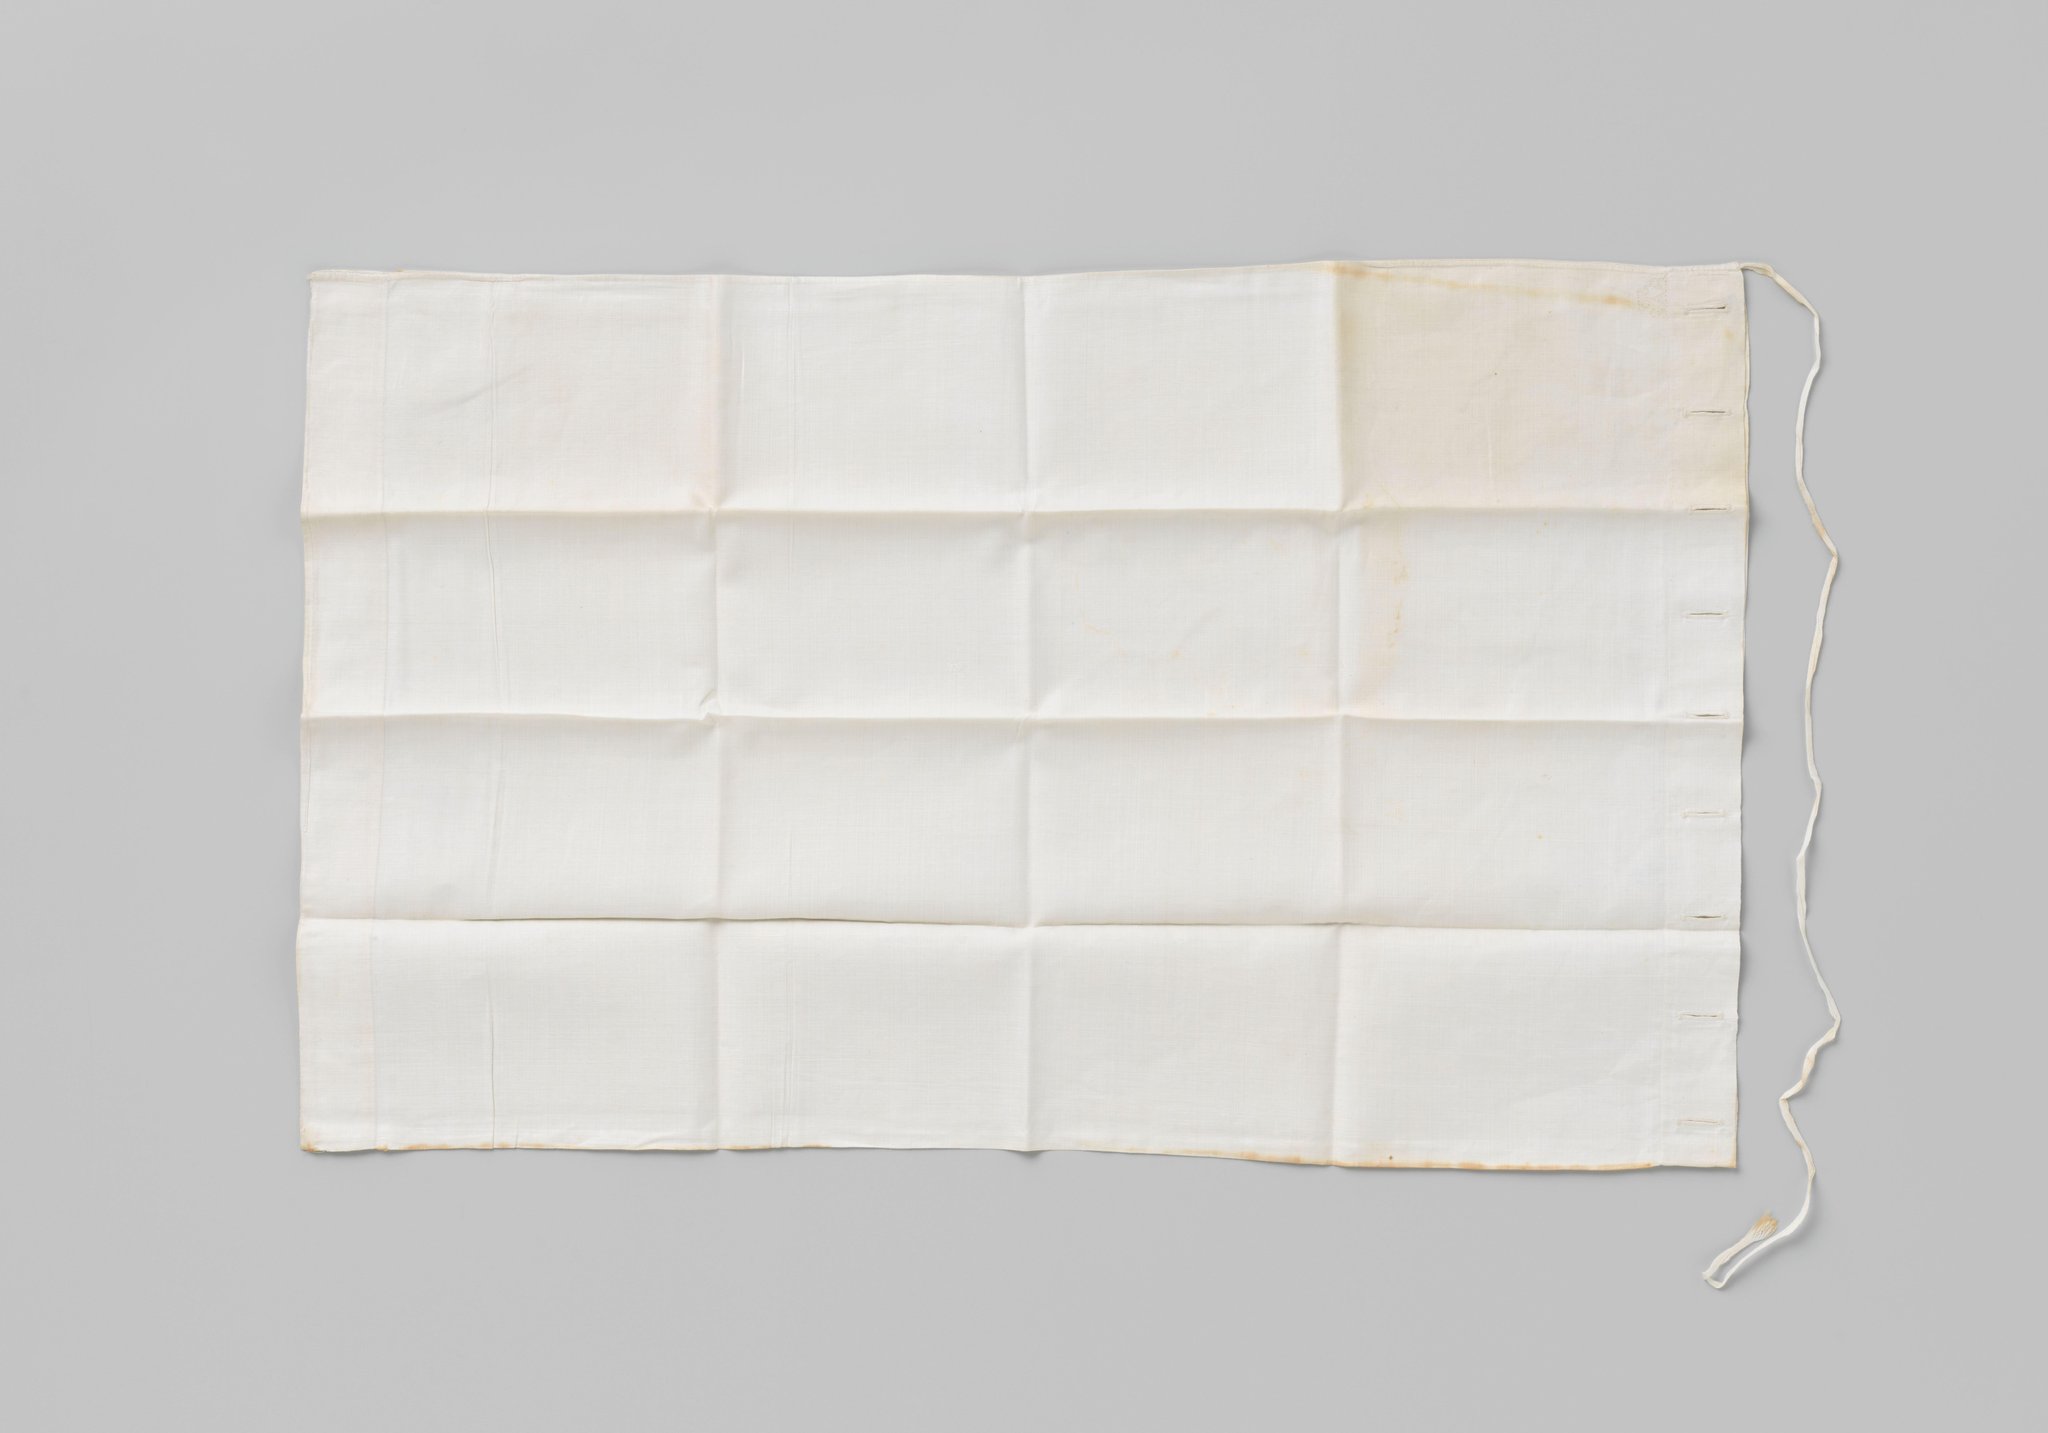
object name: lendensloop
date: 1760-1792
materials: linen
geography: northern netherlands